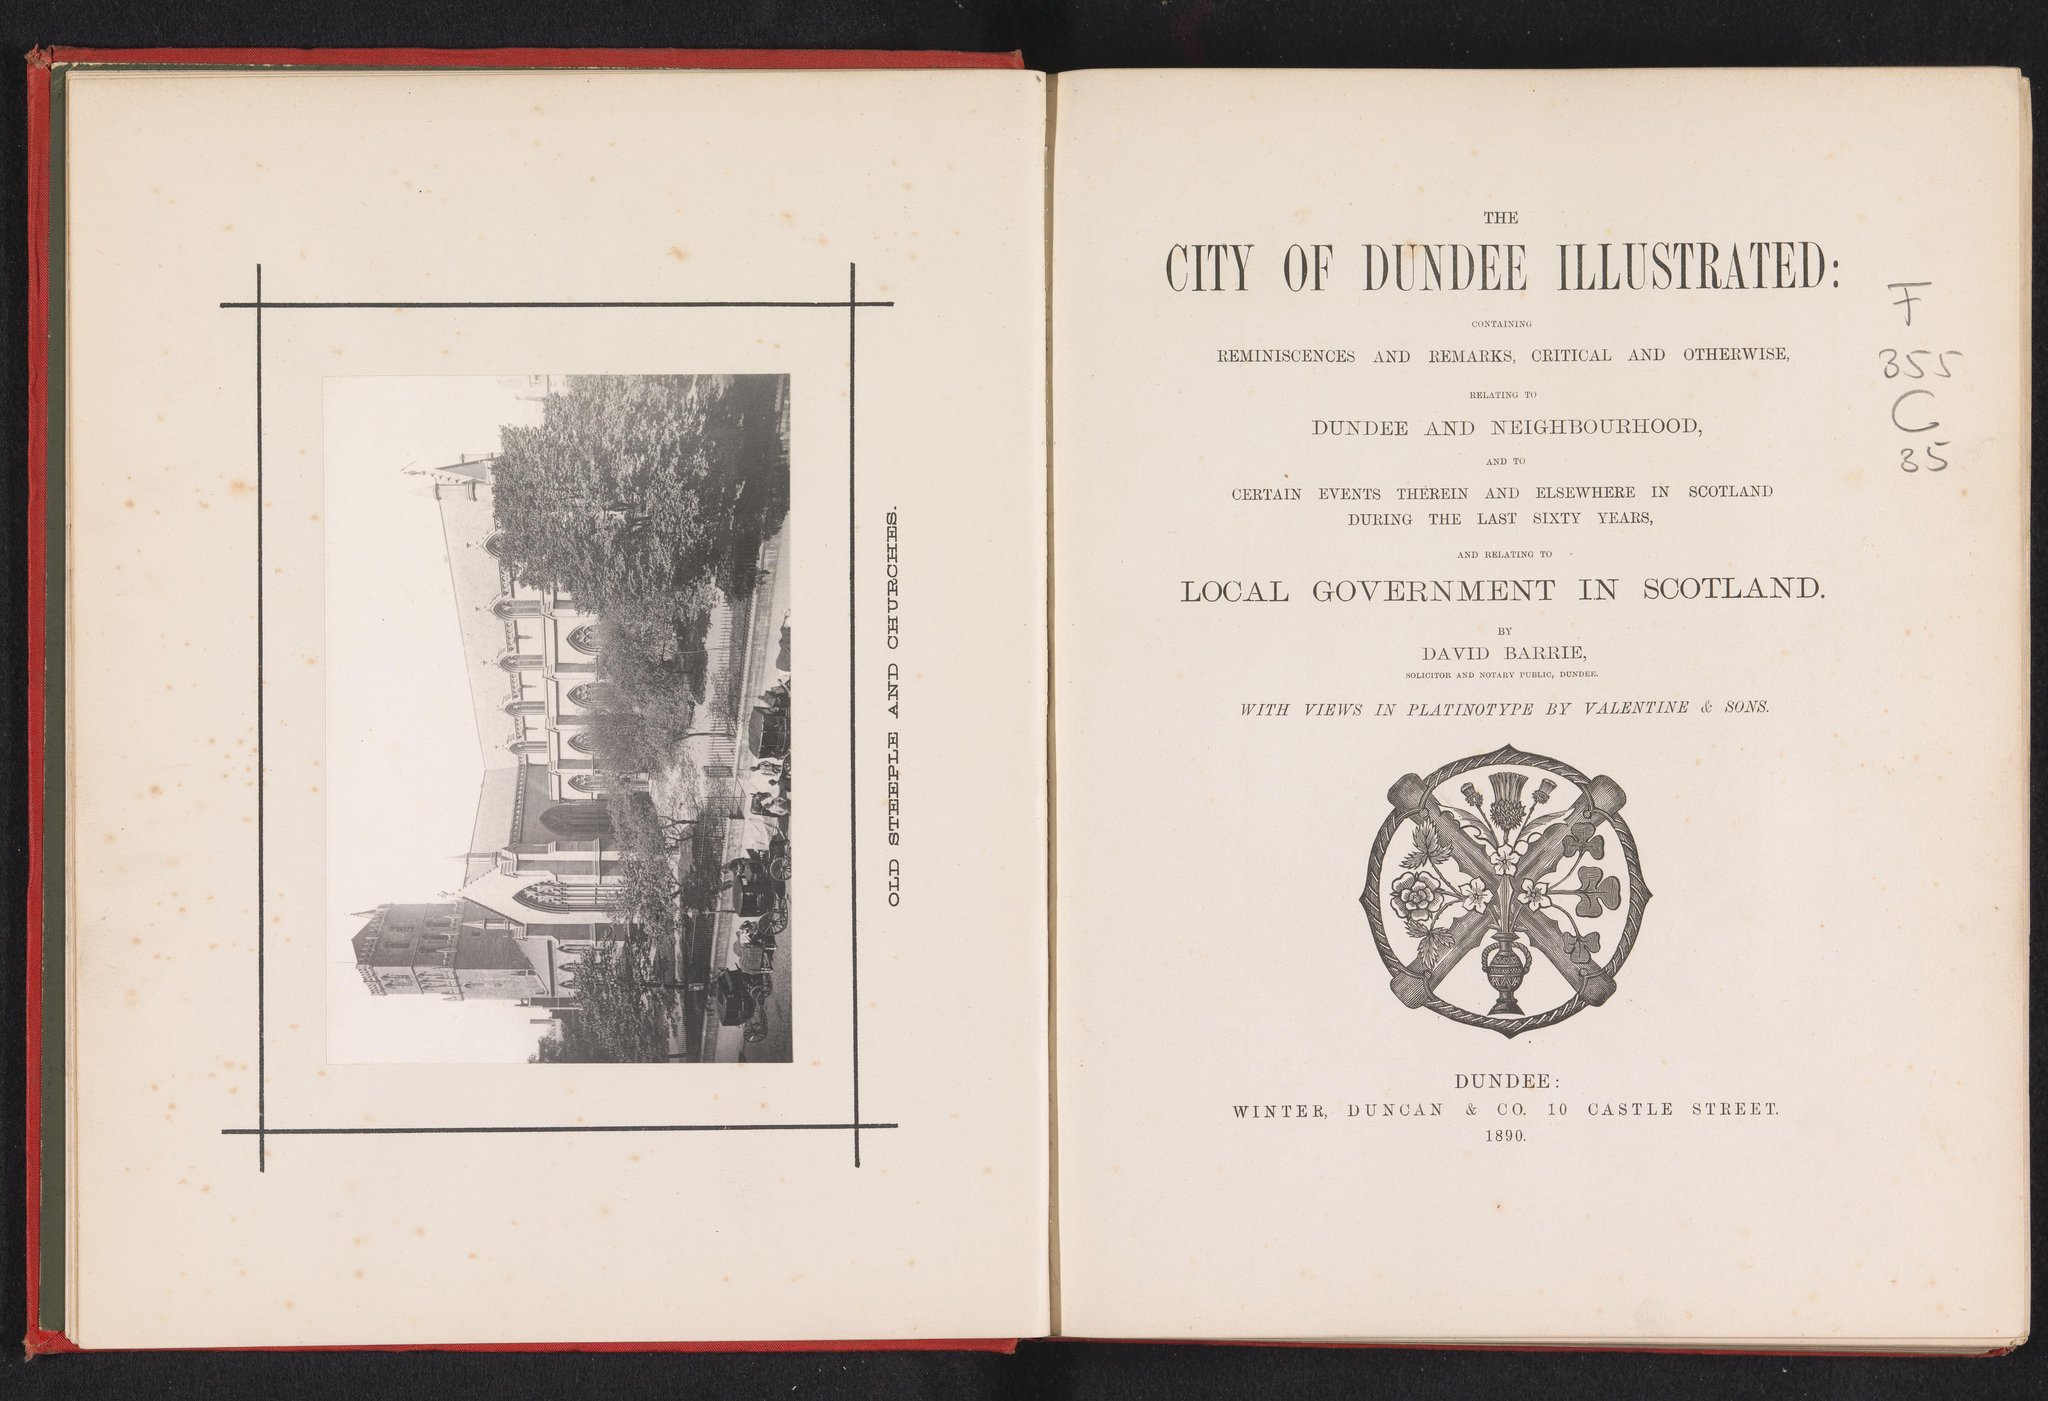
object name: book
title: The city of Dundee illustrated: containing reminiscences and remarks, critical and otherwise relating to Dundee and neighbourhood ...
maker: david barrie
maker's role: schrijver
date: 1890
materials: cardboard, linen, paper, photographic support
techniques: lithograph, platinum process, printing, engraving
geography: dundee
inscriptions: bookplate: ‘EX LIBRIS SFJ apr 1982’